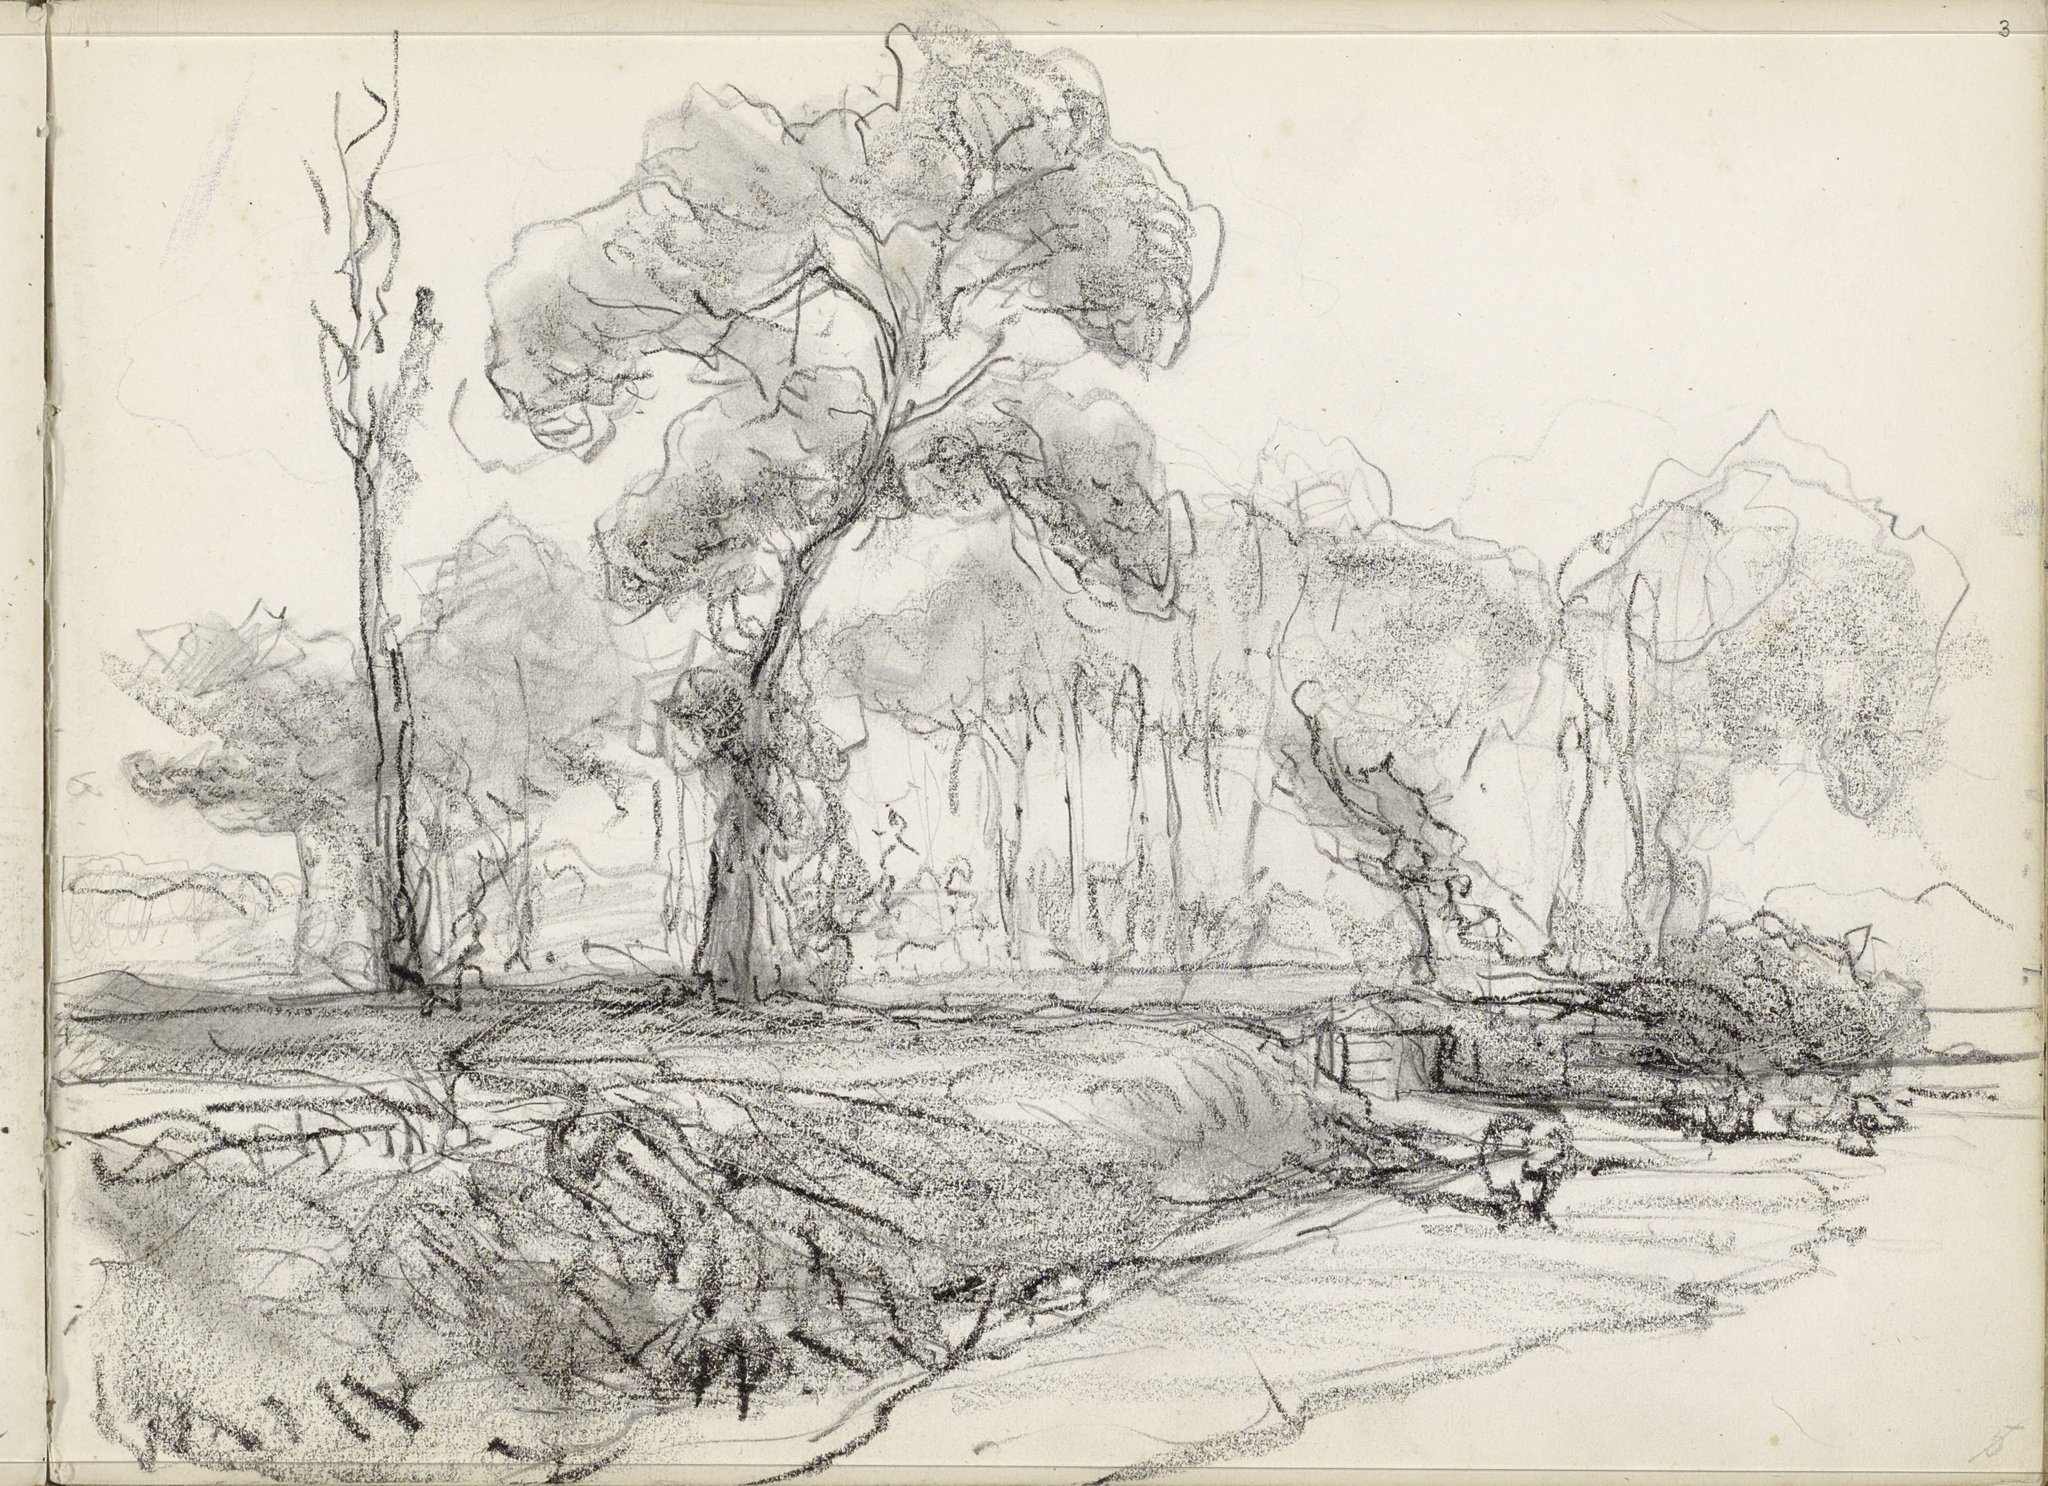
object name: sketchbook leaf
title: Landschap met bomen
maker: johannes bosboom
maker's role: draughtsman, painter, print maker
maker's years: 1817-1891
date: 1827-1891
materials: chalk, paper, pencil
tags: landscapes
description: Blad 3 recto uit een schetsboek met 13 bladen.